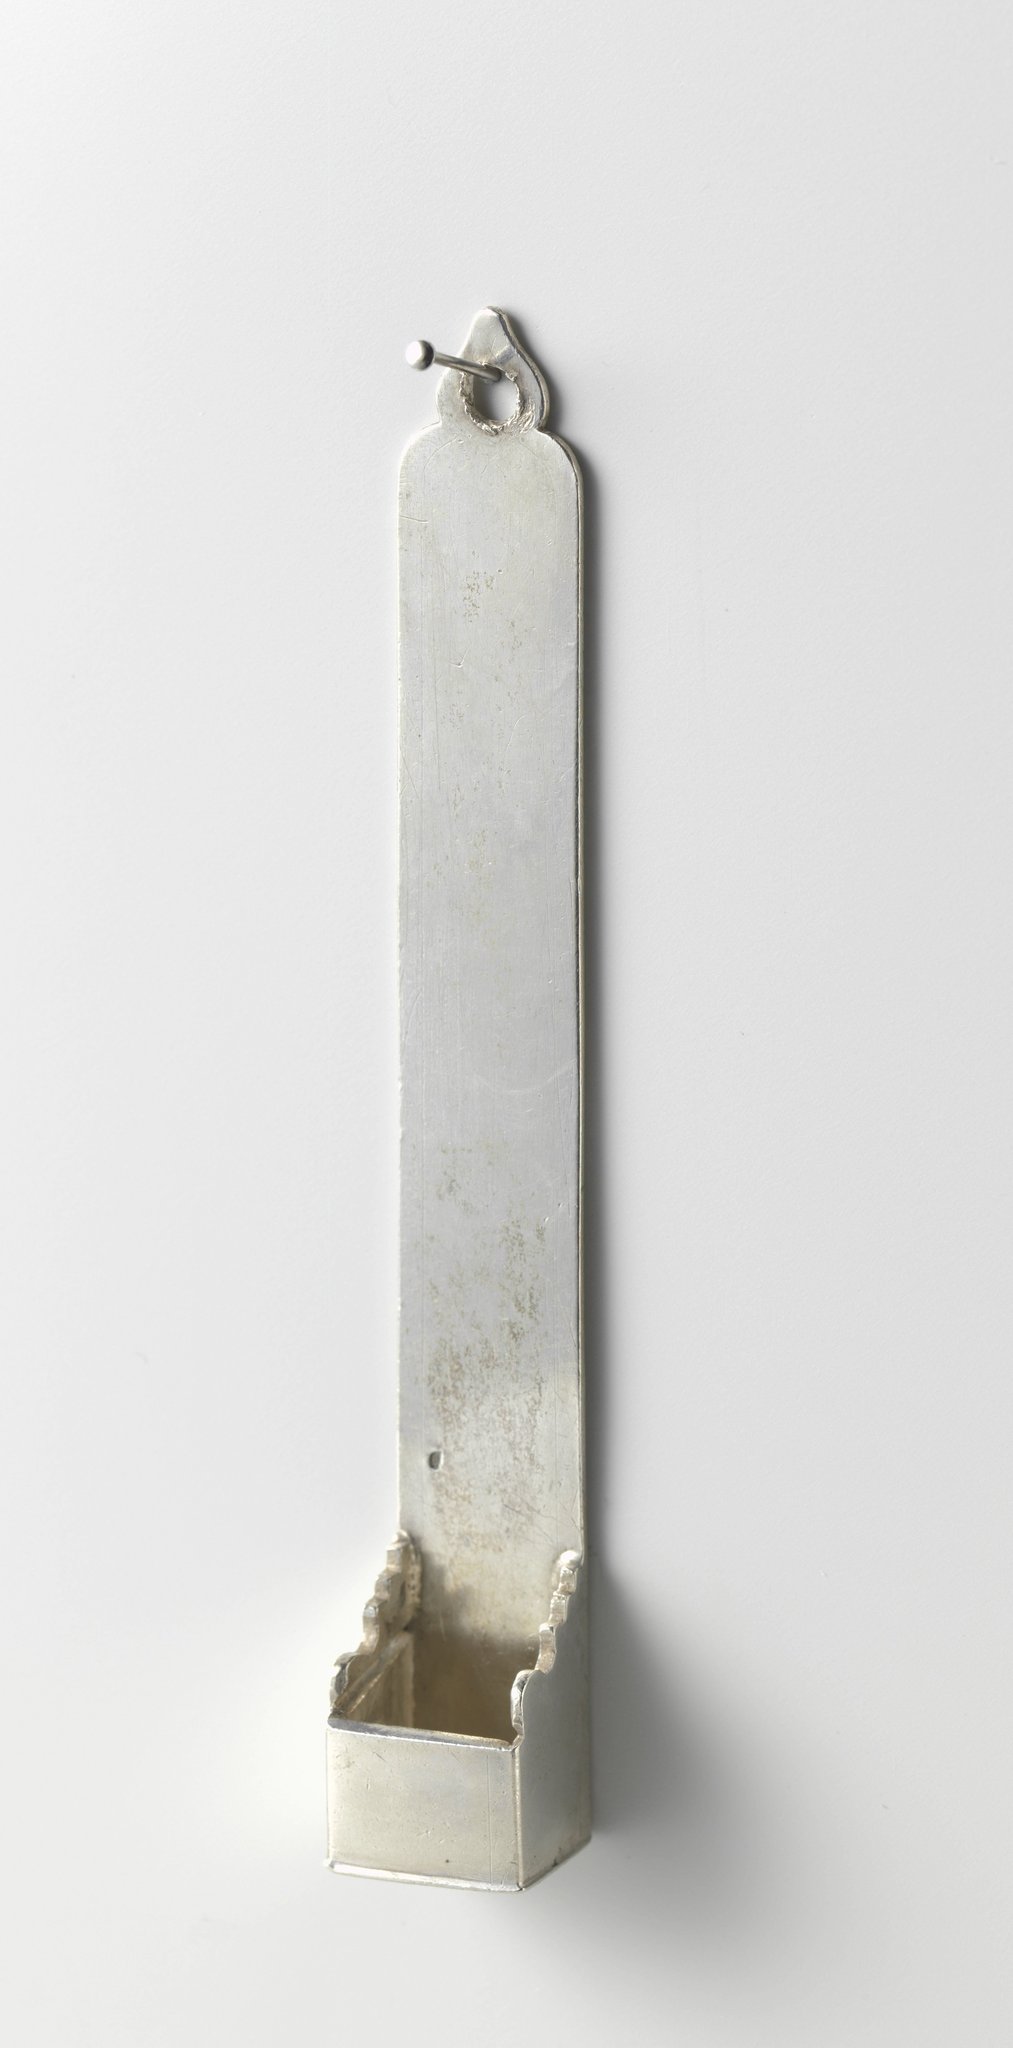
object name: miniature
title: Schuurplank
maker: willem van strant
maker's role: silversmith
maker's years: 1682-1742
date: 1730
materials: silver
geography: amsterdam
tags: (household) utensils and implements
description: Schuurplank met bovenaan een draagoog. Onderaan zit een bak waarvan de schuif ontbreekt. De plank is gemerkt: stk.= Amsterdam, mt.= Willem van Strant en een zwijnskop.